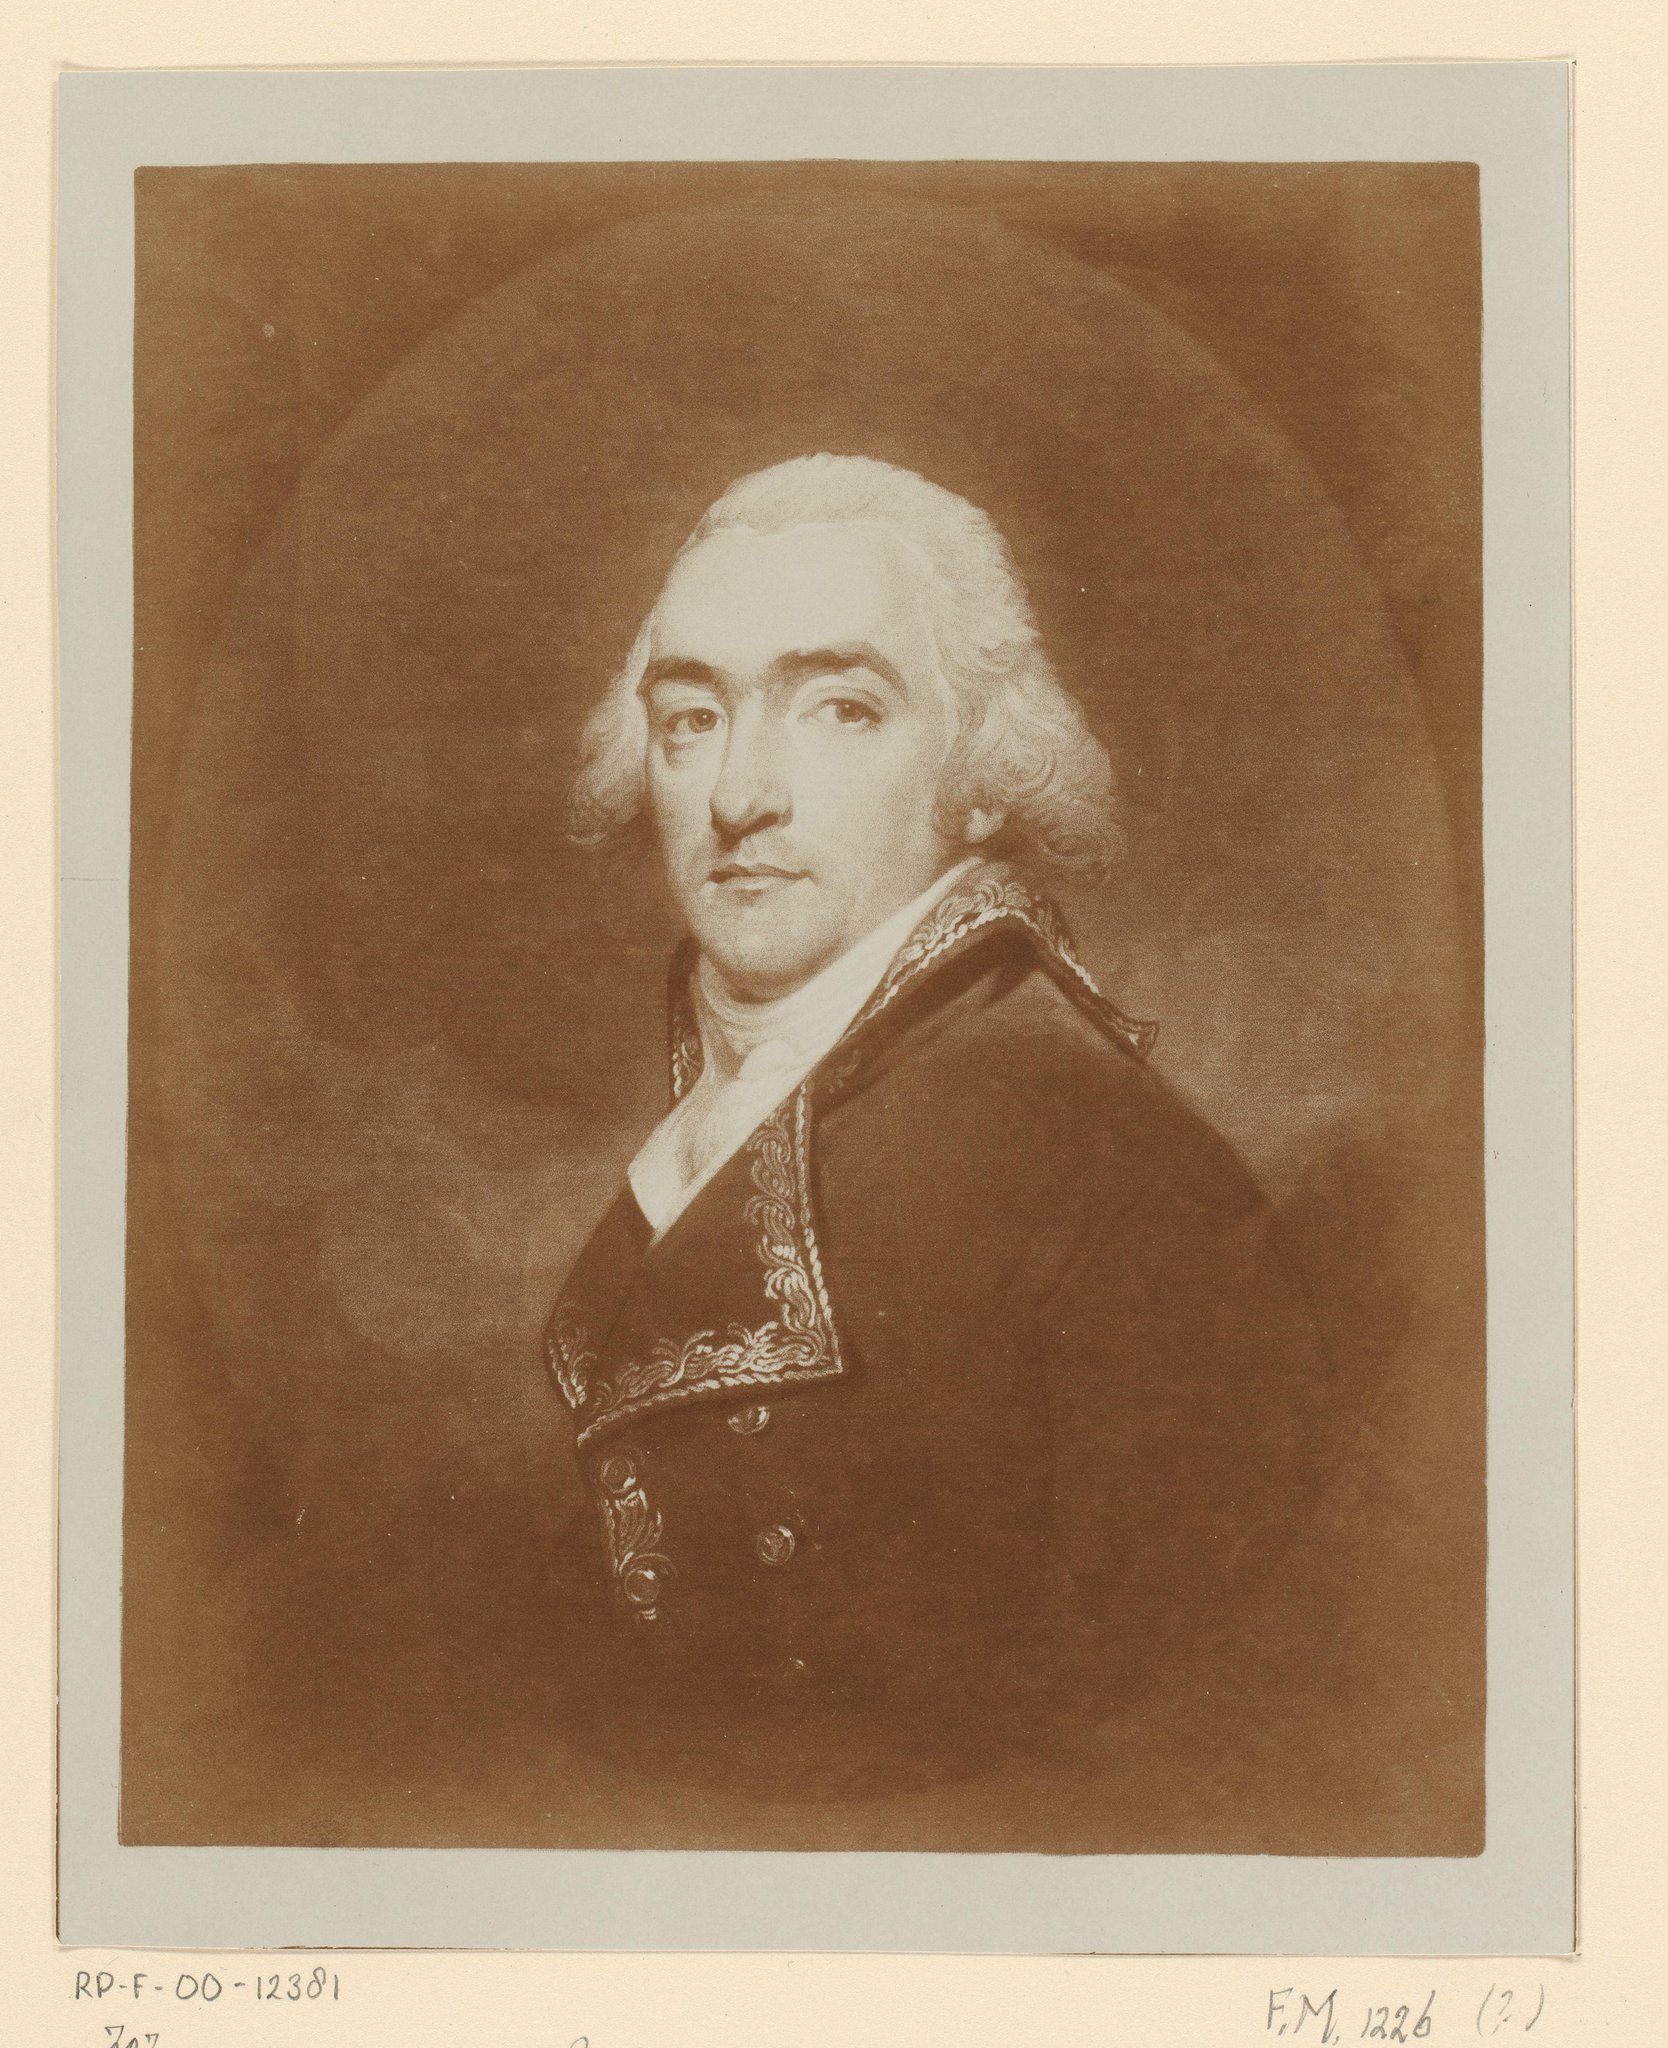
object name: reproduction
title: Fotoreproductie van een geschilderd portret van Herman Willem Daendels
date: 1900-1950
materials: paper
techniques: gelatin silver print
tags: herman willem daendels, historical persons, picture, painting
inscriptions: inscription: ‘Daendels./ Ch. Hodges zw.k.’